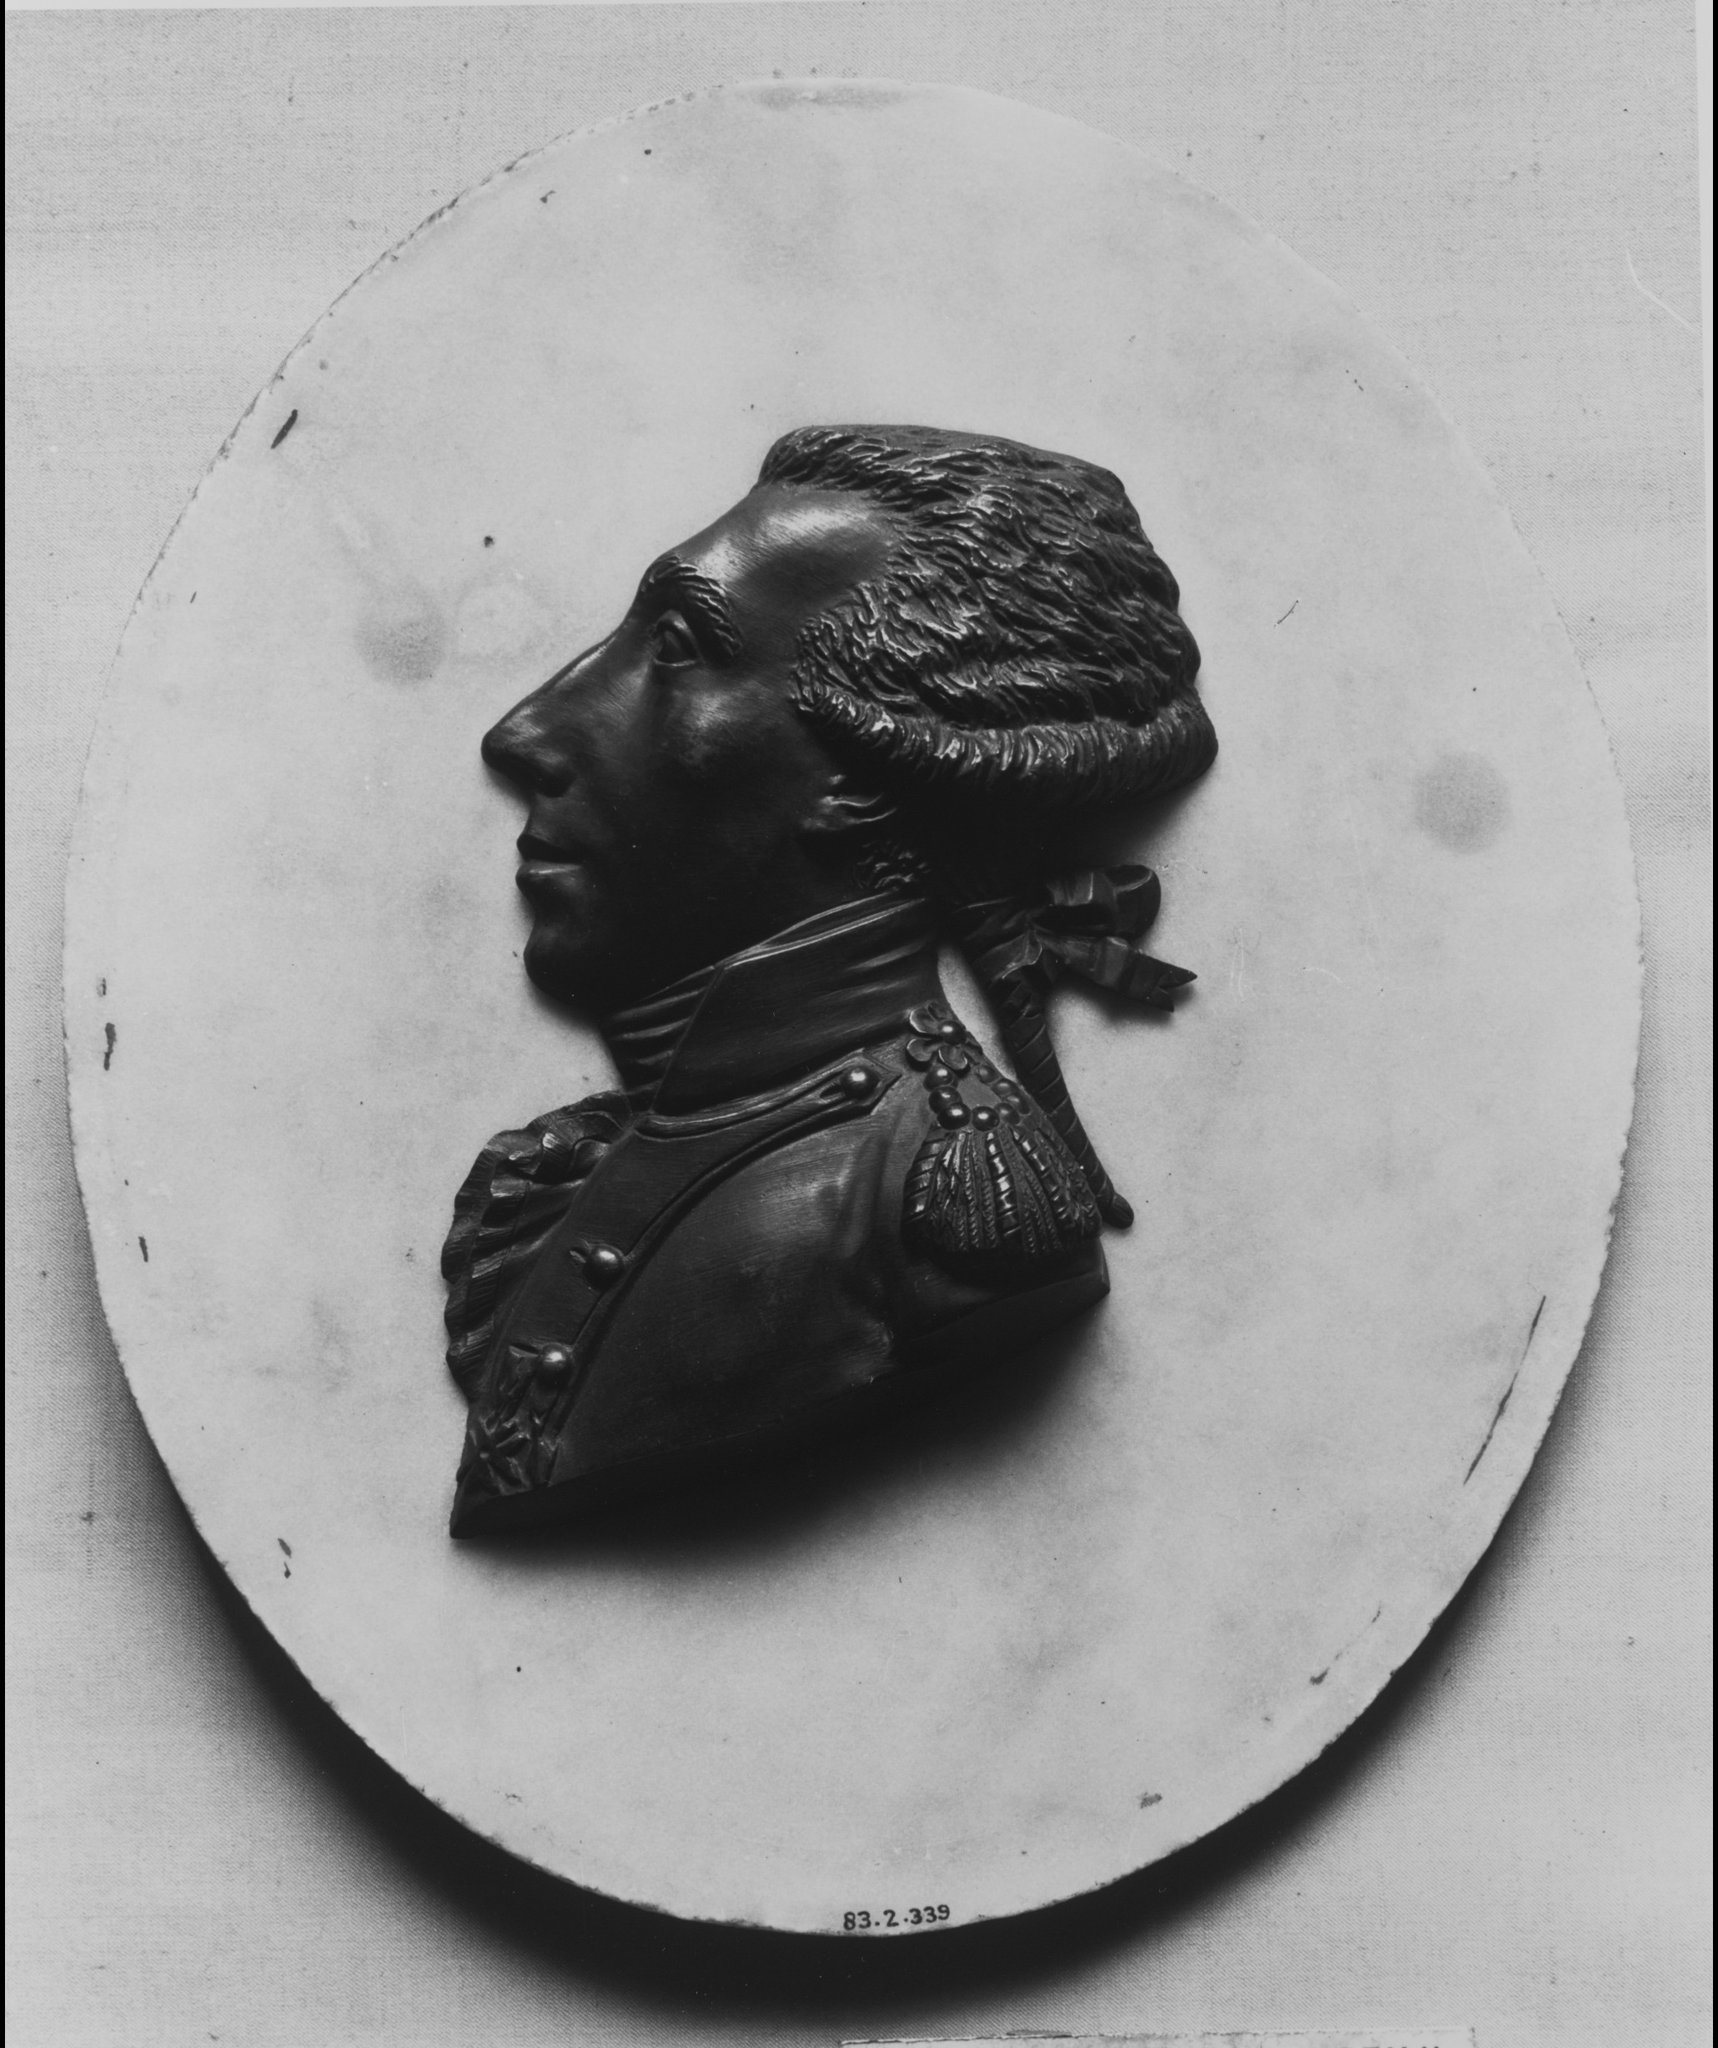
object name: plaque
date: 1800-1883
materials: brass, marble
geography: france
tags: men,profiles